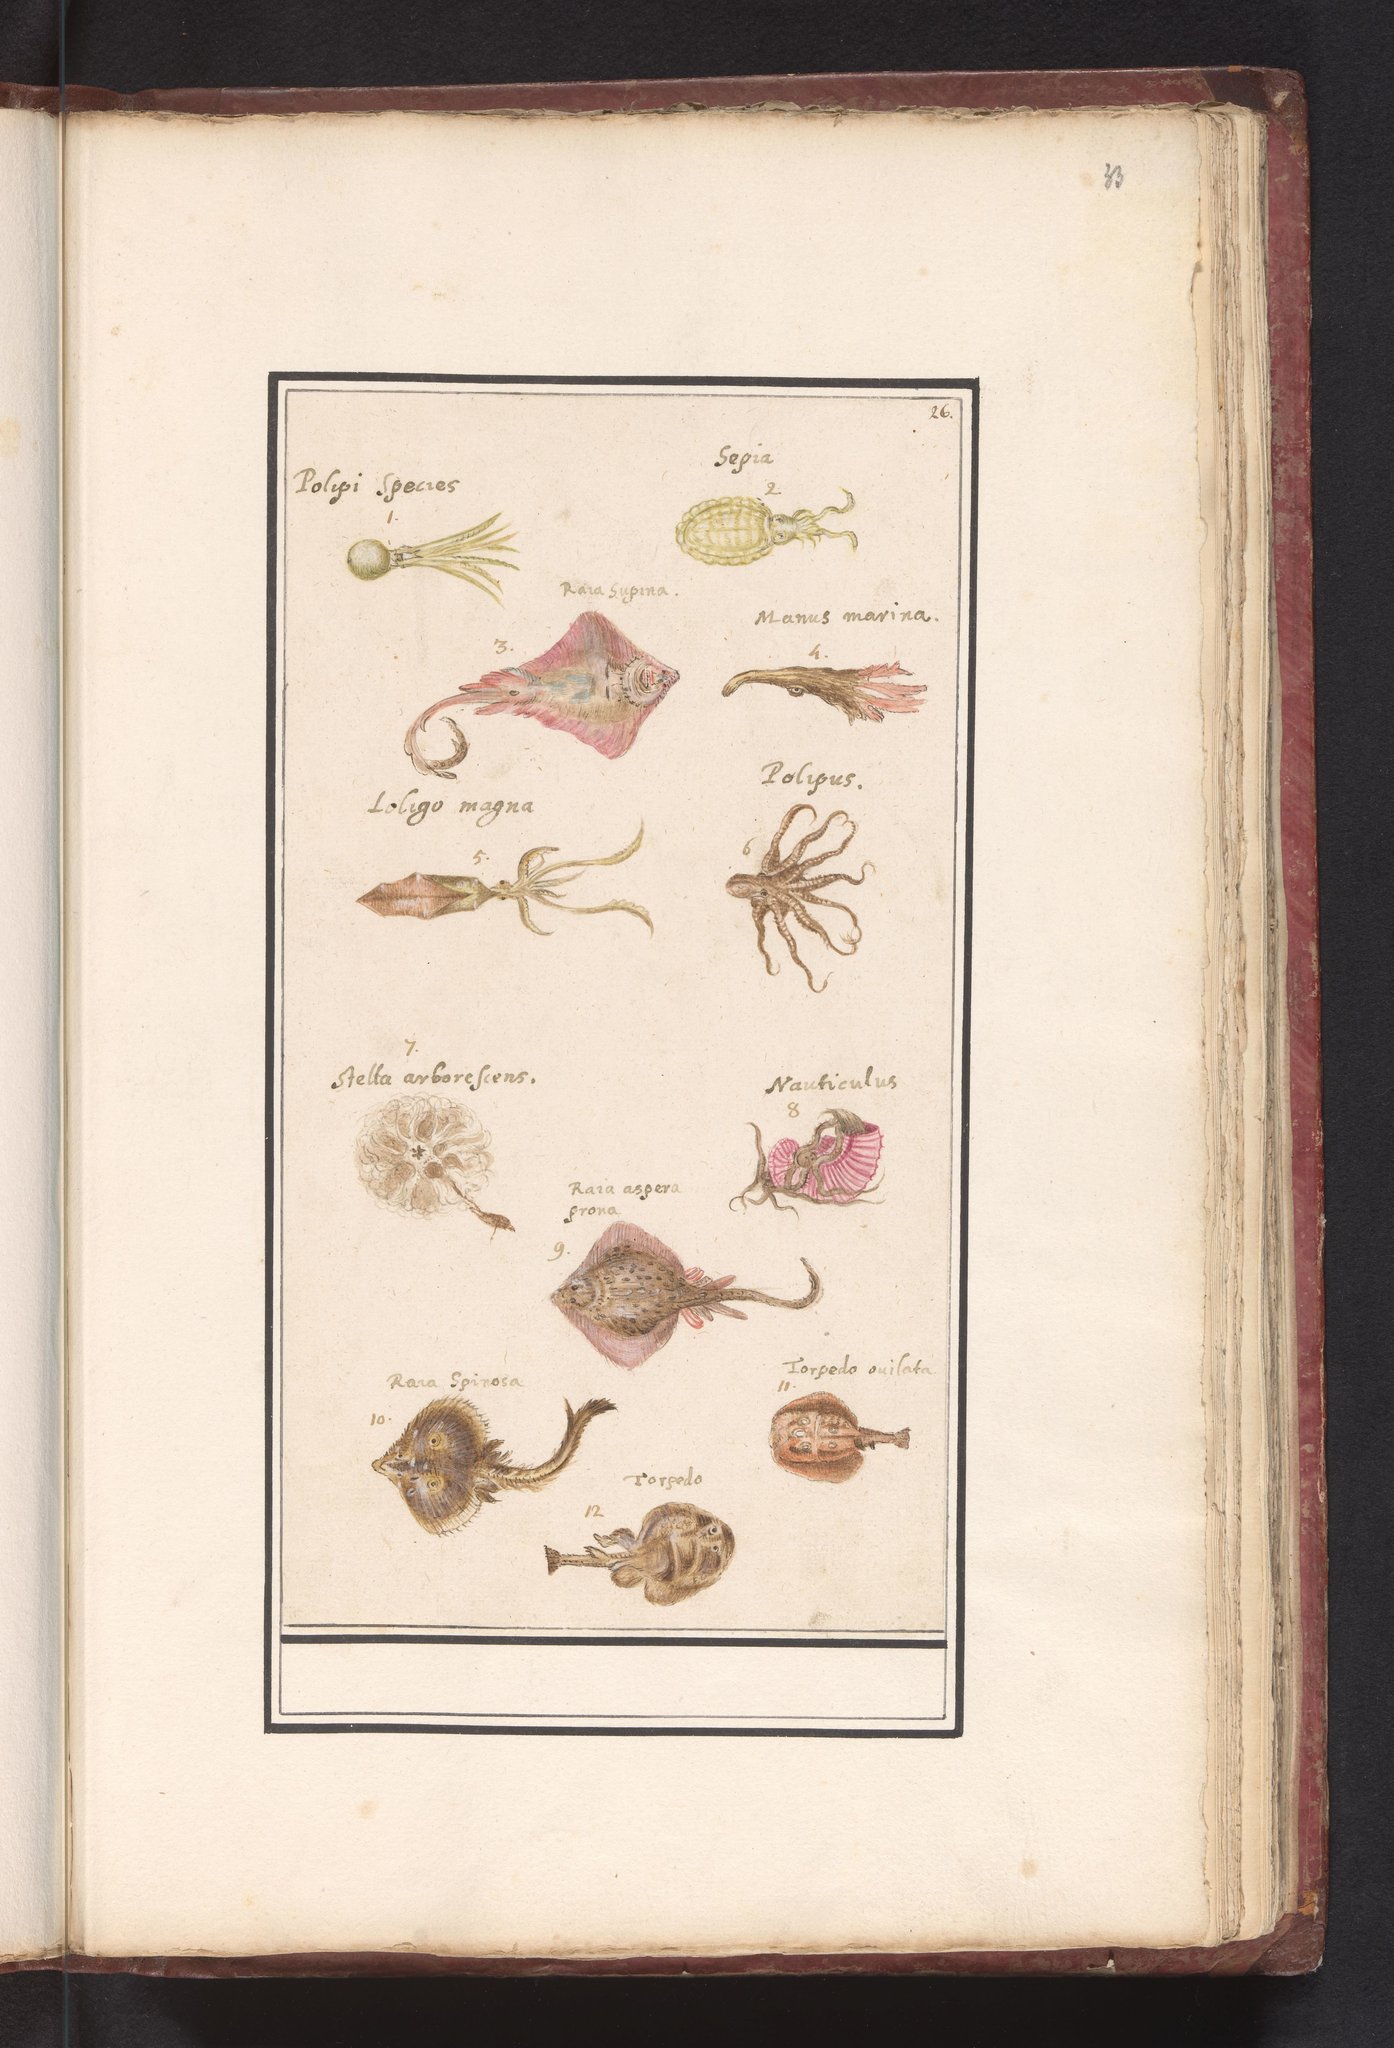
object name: drawing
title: Blad met twaalf vissen en inktvissen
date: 1596-1610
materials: paint, ink, paper, watercolor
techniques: brush, pen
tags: molluscs: squid, molluscs: octopus, fishes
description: Blad met twaalf vissen en inktvissen, genummerd 1-12. Met de Latijnse namen. Genummerd rechtsboven: 26. Onderdeel van het zesde album met tekeningen van vissen, schelpen en insekten. Zesde van twaalf albums met tekeningen van dieren, vogels en planten bekend rond 1600, gemaakt in opdracht van keizer Rudolf II. Met toelichting in Nederlands, Latijn en Frans.